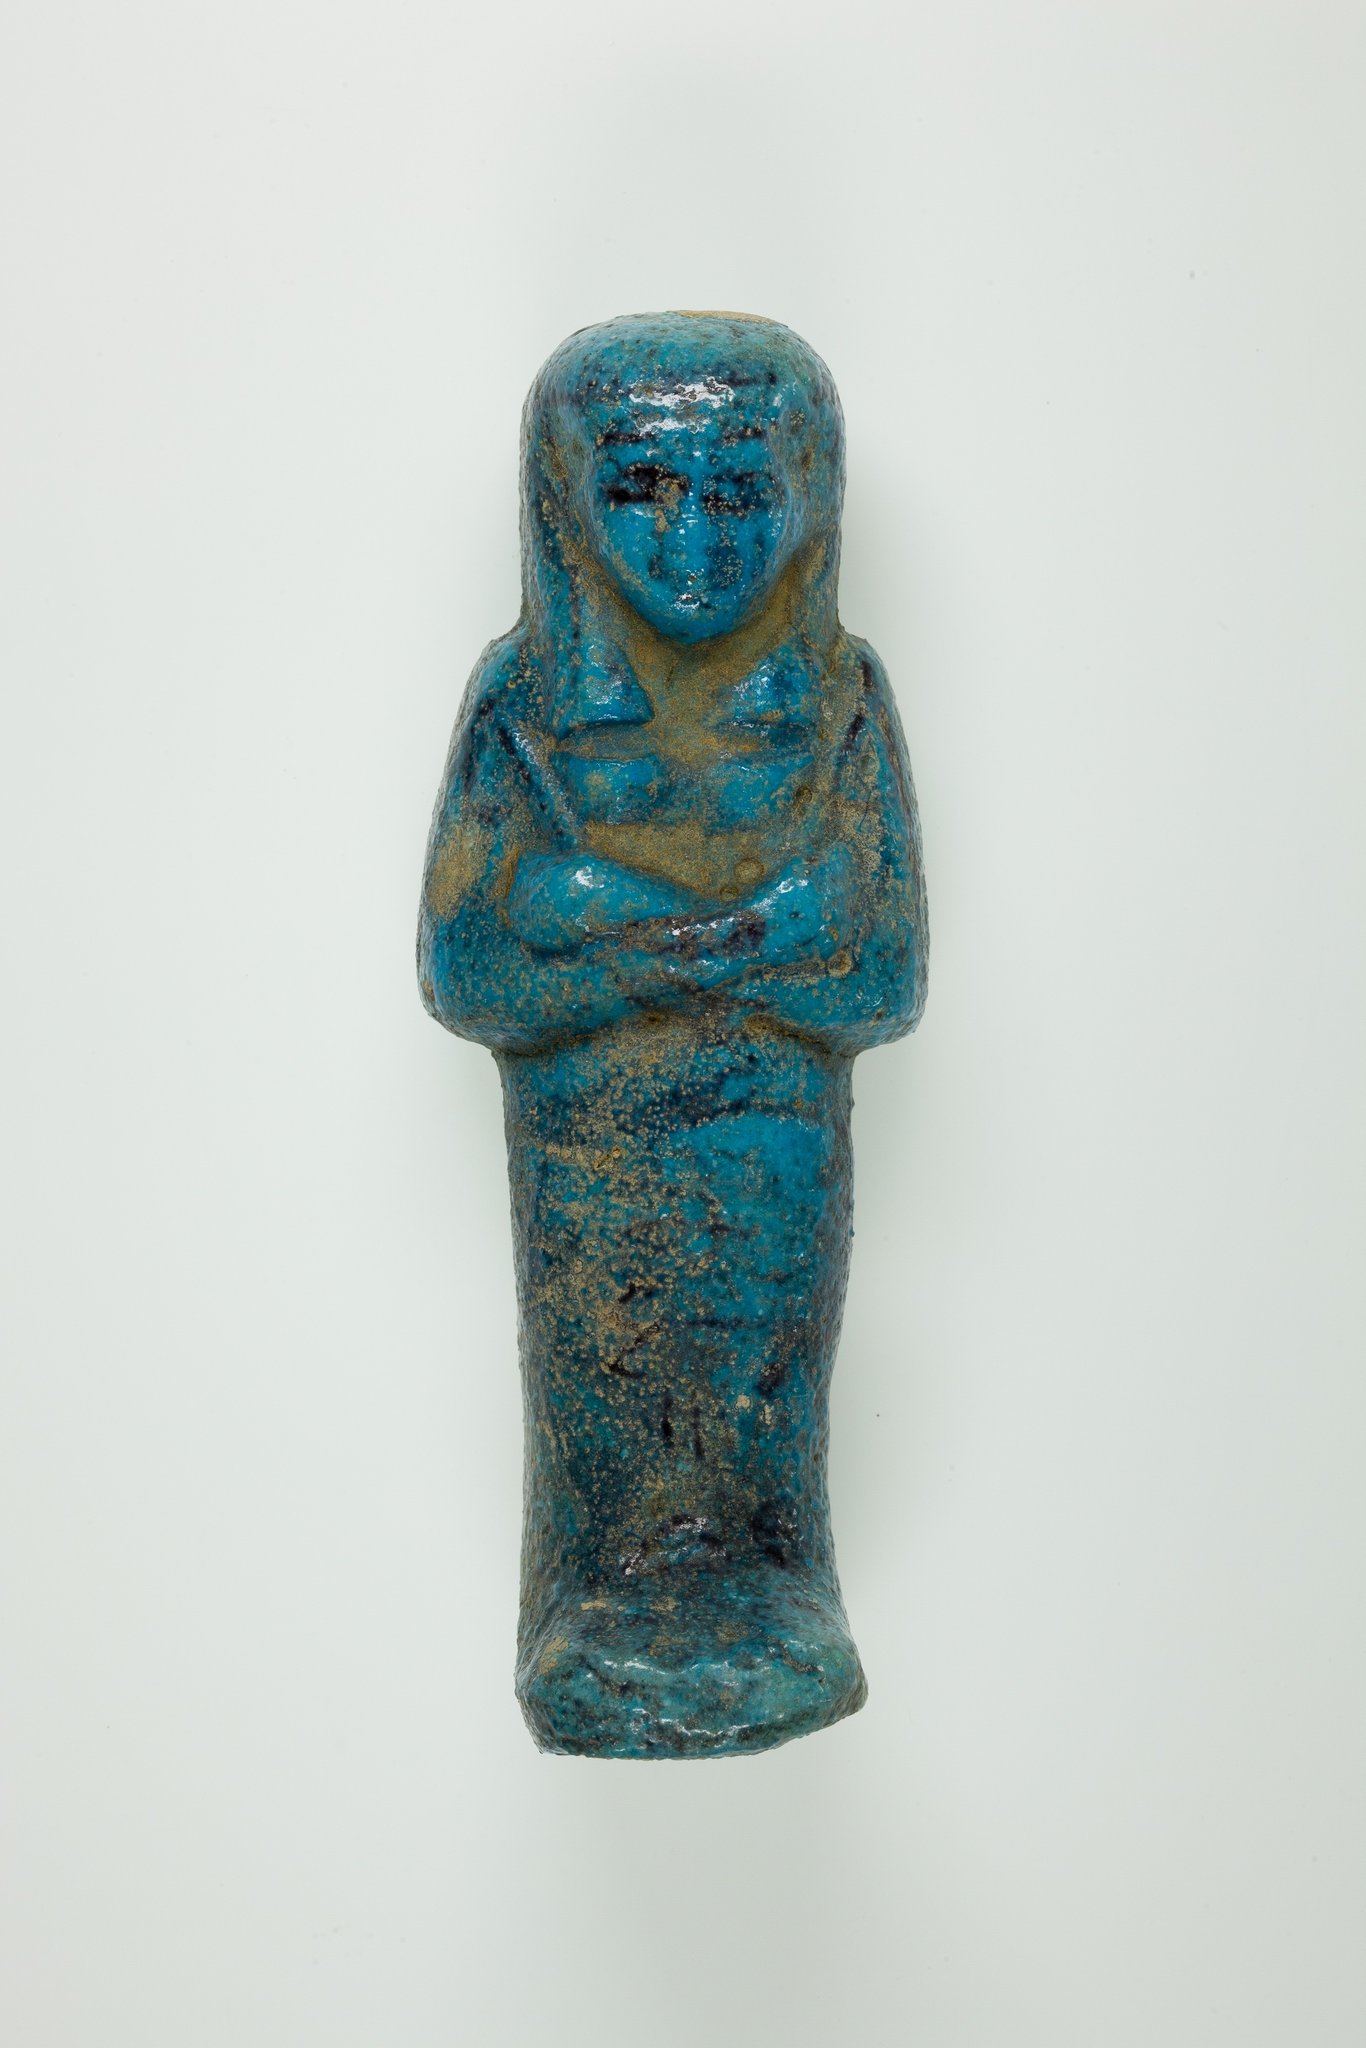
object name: worker shabti, henettawy c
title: Worker Shabti of Henettawy (C), Daughter of Isetemkheb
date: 990-970 BCE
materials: faience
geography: egypt